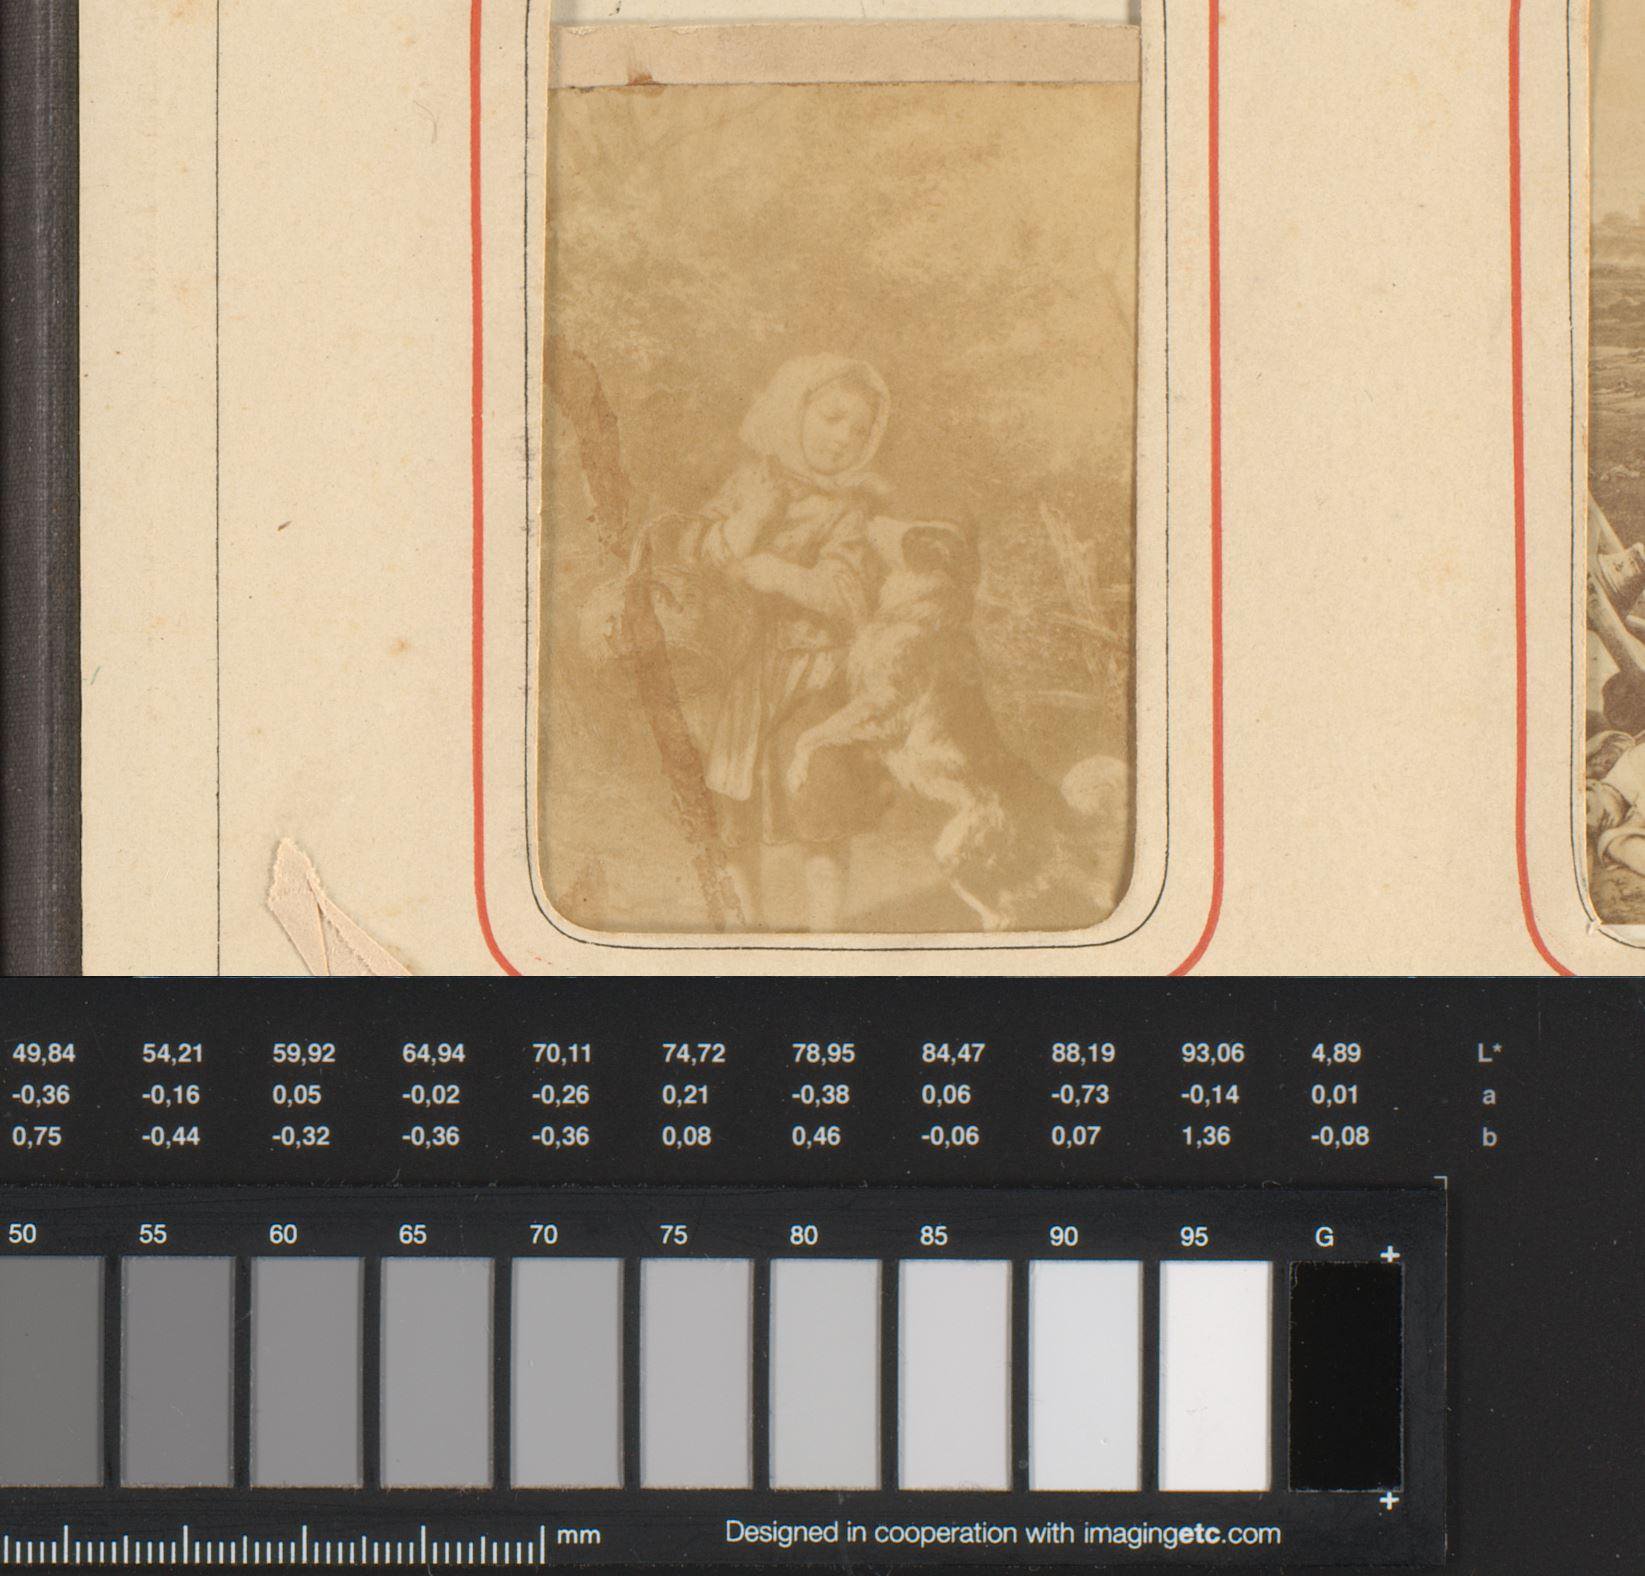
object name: album leaf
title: Fotoreproductie van een schilderij van een meisje met een hond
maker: Anonymous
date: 1870-1890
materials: cardboard, paper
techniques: albumen print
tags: girl (child between toddler and youth), dog